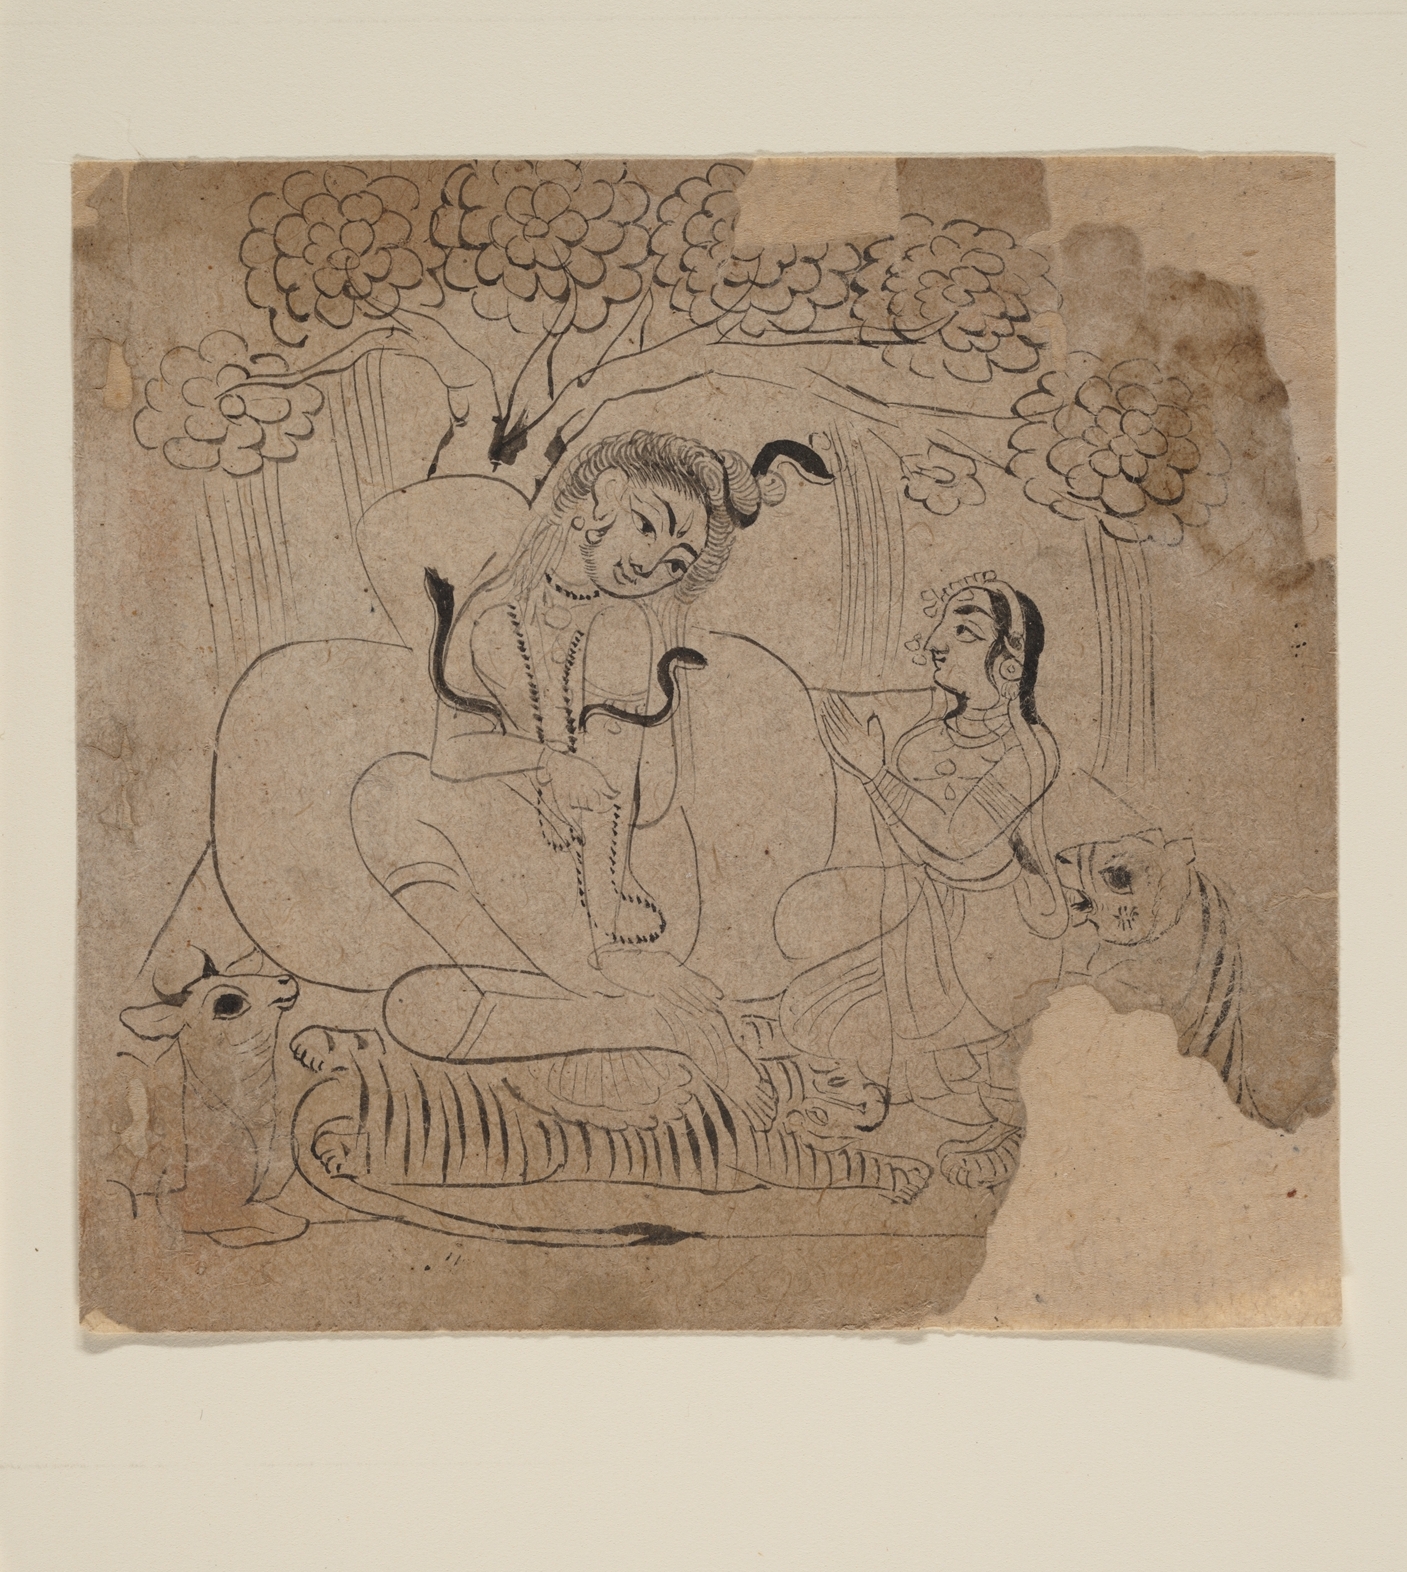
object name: painting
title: Shiva and Parvati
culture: india, pahari hills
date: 1801-1900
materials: ink, paper, watercolor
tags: bulls,snakes,parvati,shiva